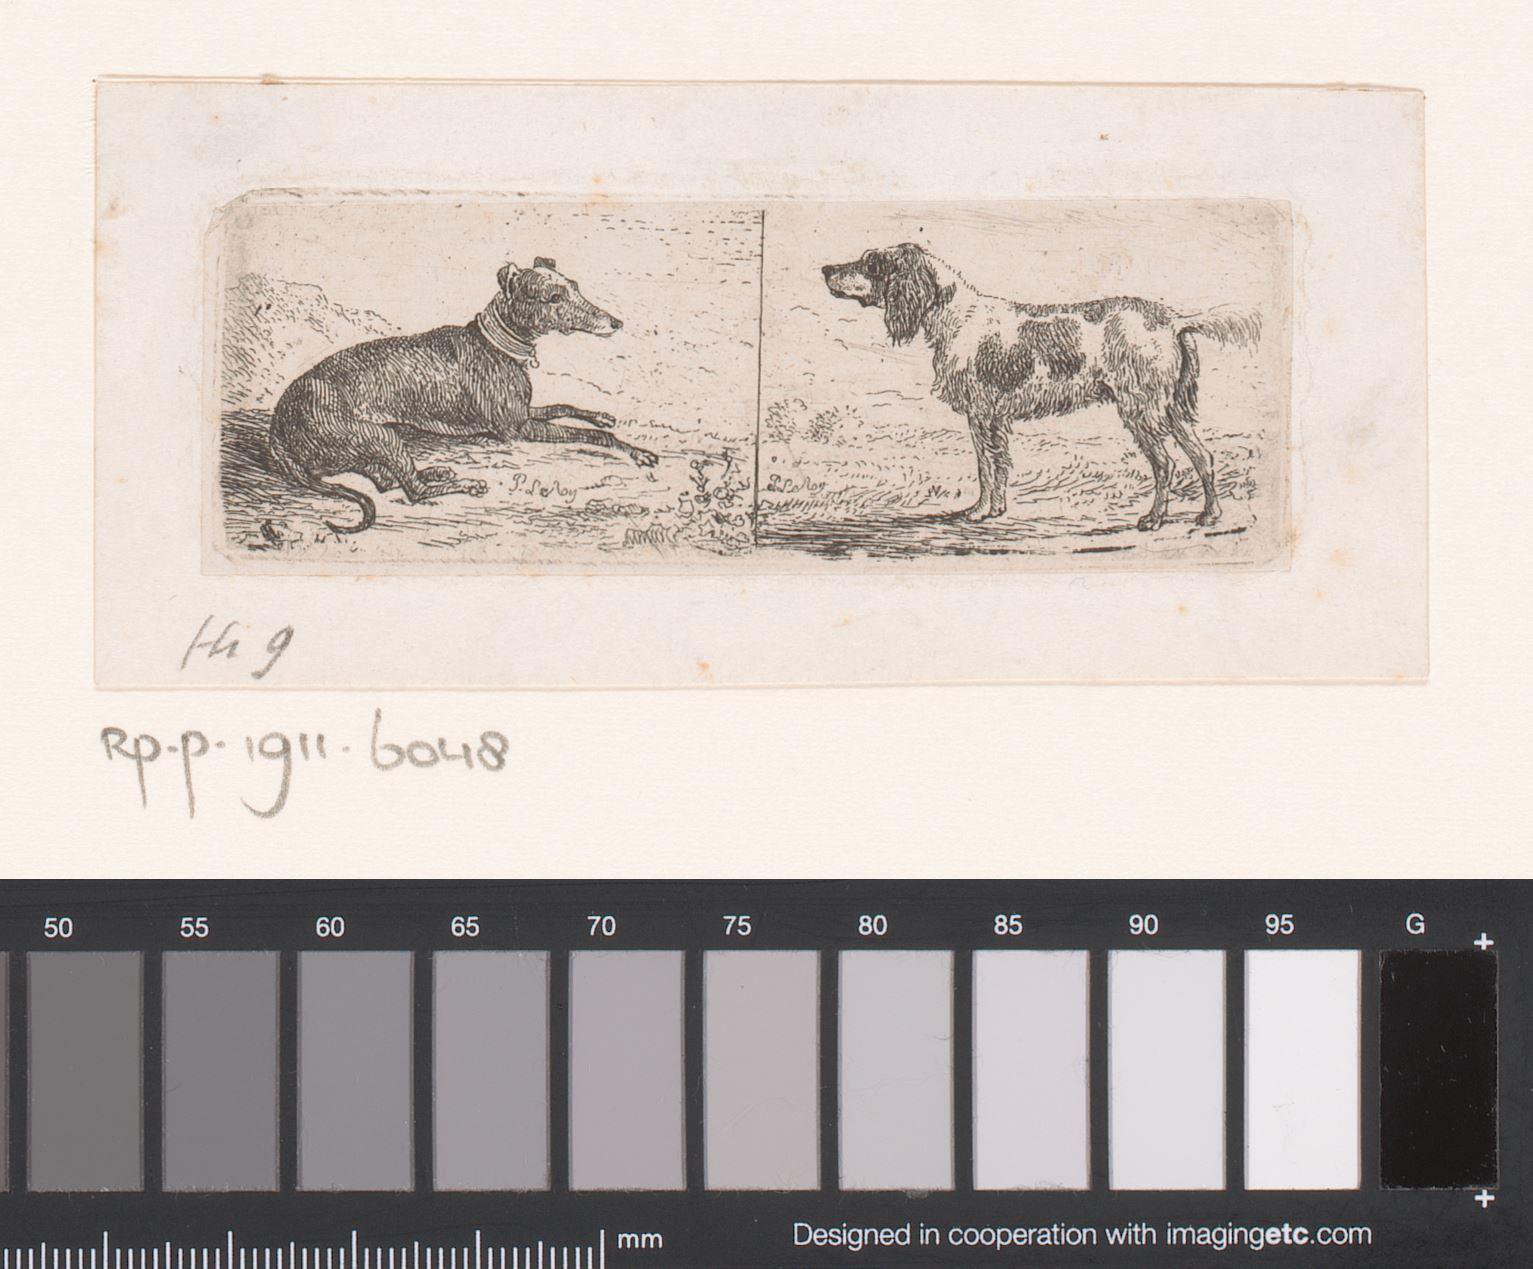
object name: print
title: Liggende windhond en staande spaniël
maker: pierre-françois le roy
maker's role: draughtsman, painter, print maker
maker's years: 1771-1862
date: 1794-1862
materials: paper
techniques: etching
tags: dog (with name of kind)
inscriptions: collector's mark: Lugt 1485, collector's mark: Lugt 2228